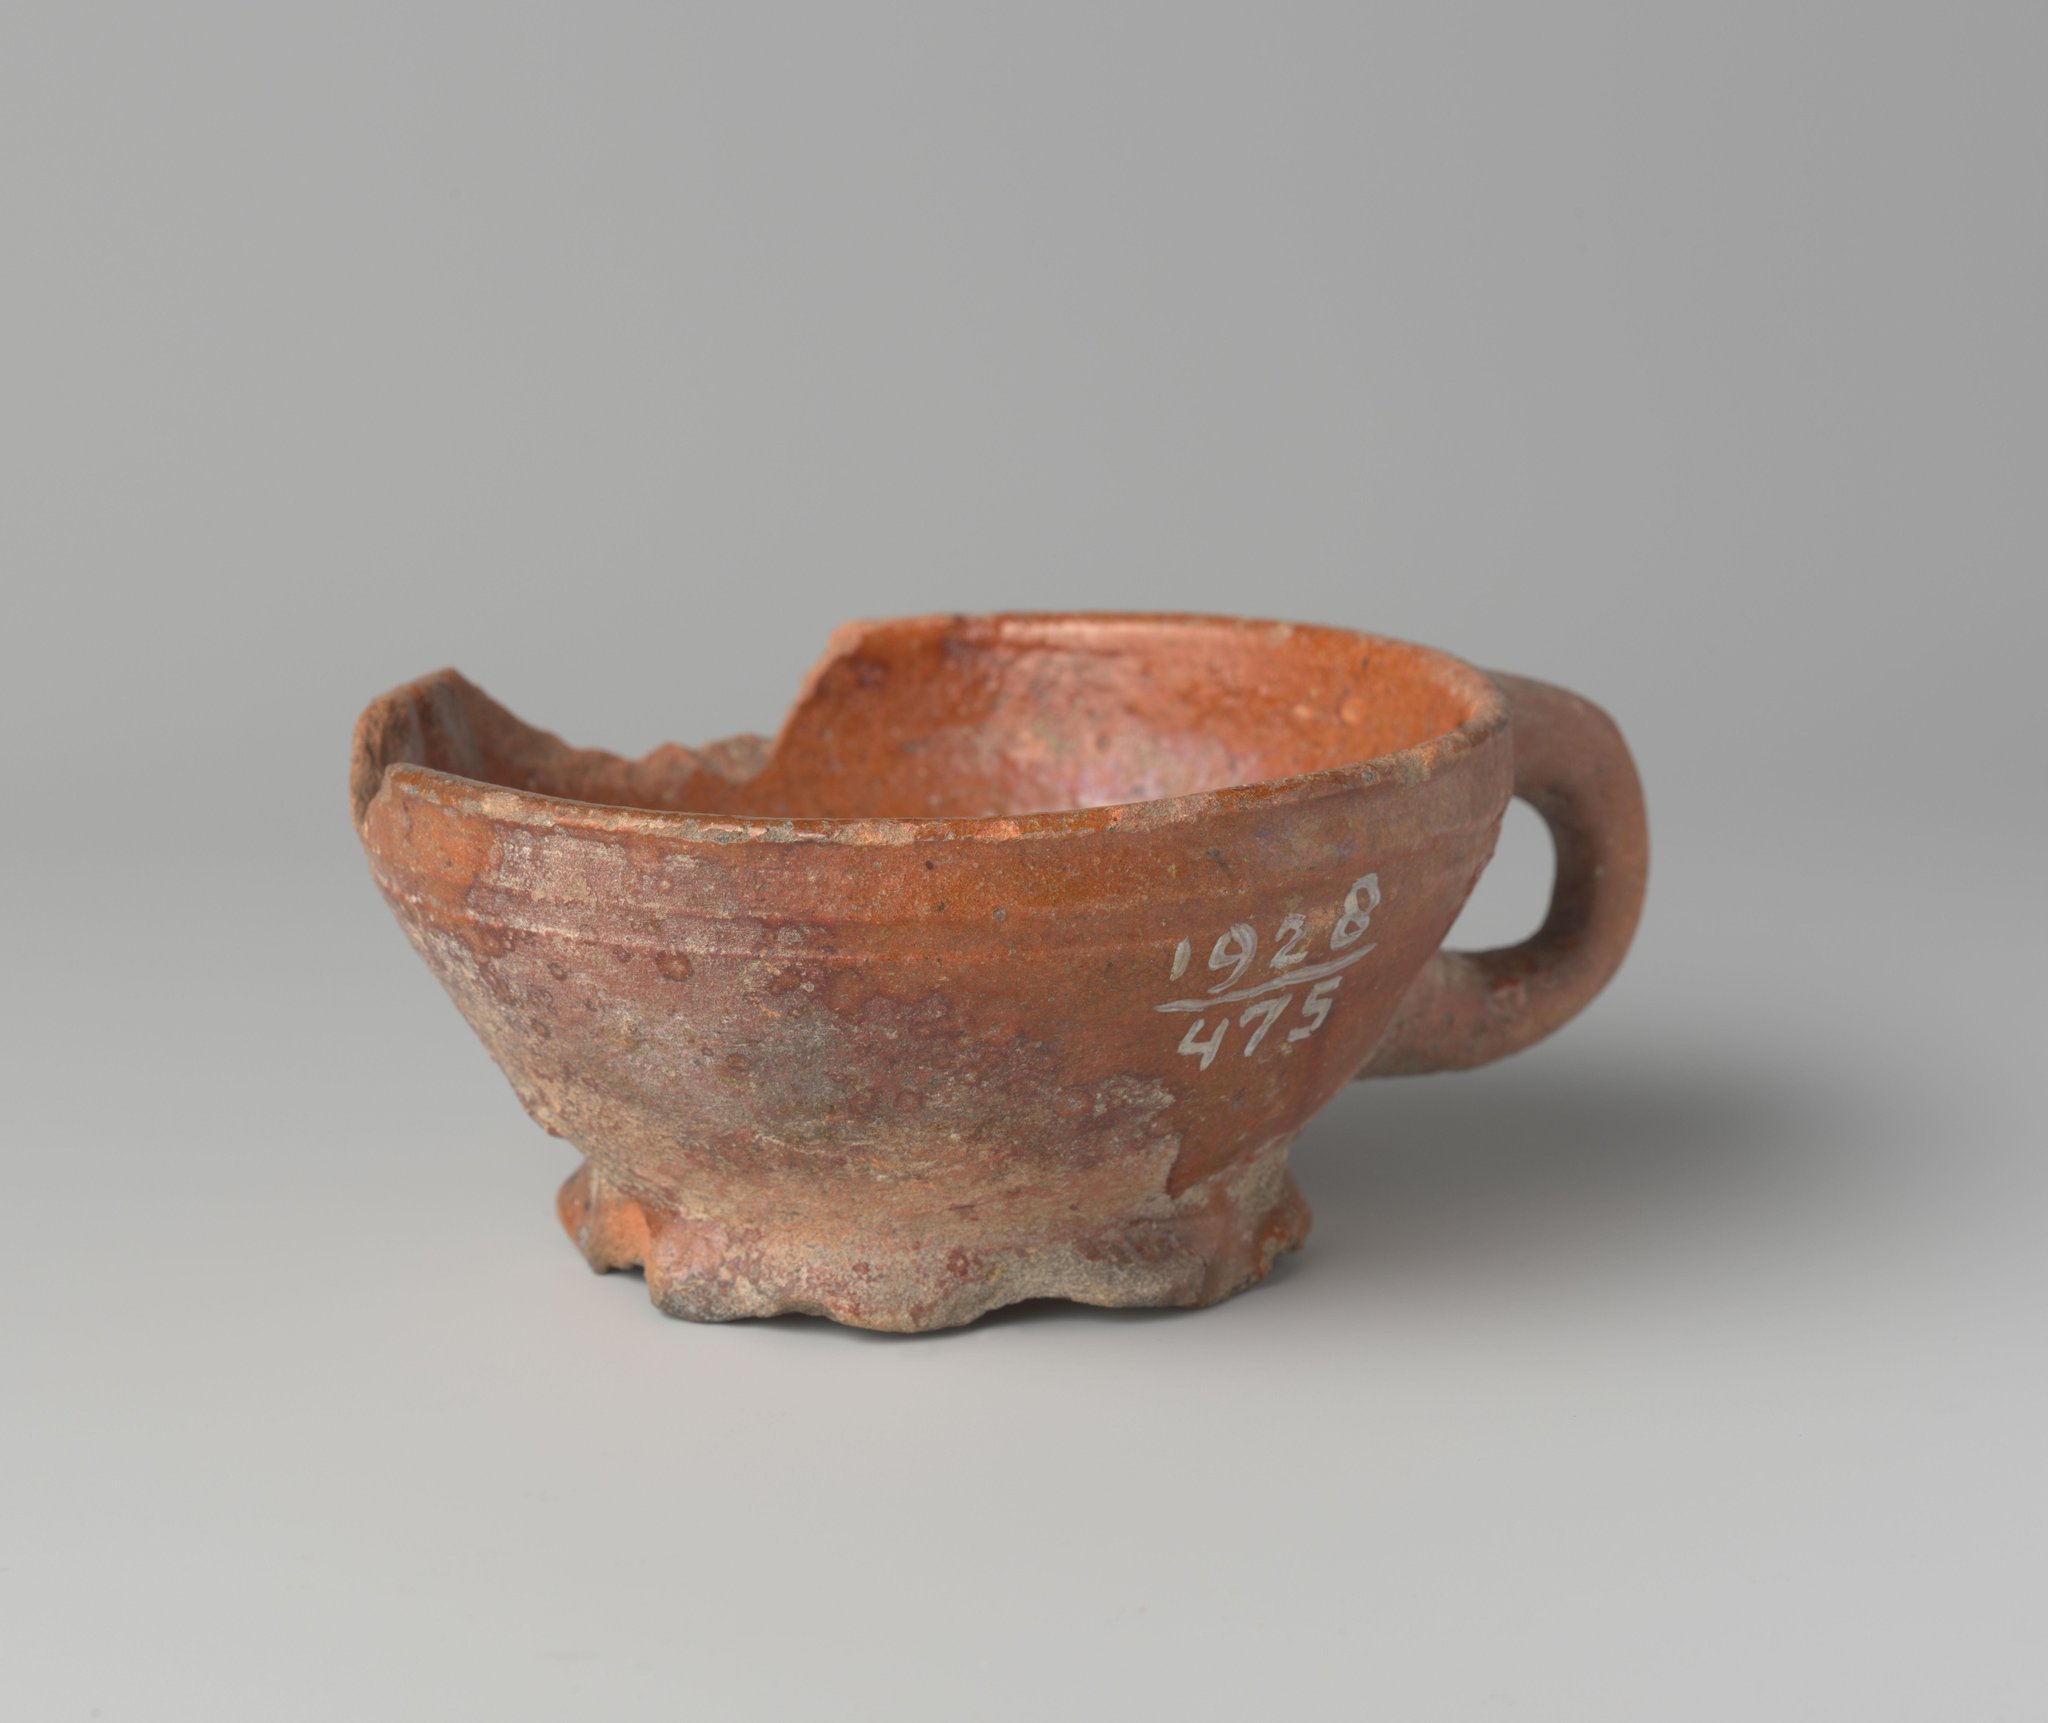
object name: container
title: Bakje van hard aardewerk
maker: Anonymous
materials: earthenware, glaze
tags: aduard abbey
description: Bakje van hard aardewerk; scherf: steenrood. Op de korte geplooide voetrand rust de schuinstaande wand met staande liprand. Voorzien van een oor. Tendele bedekt met kleurloos loodglazuur. Opmerking: gevonden bij de restauratie van de Abdij te Aduard. Toestand: geschonden bij de liprand.